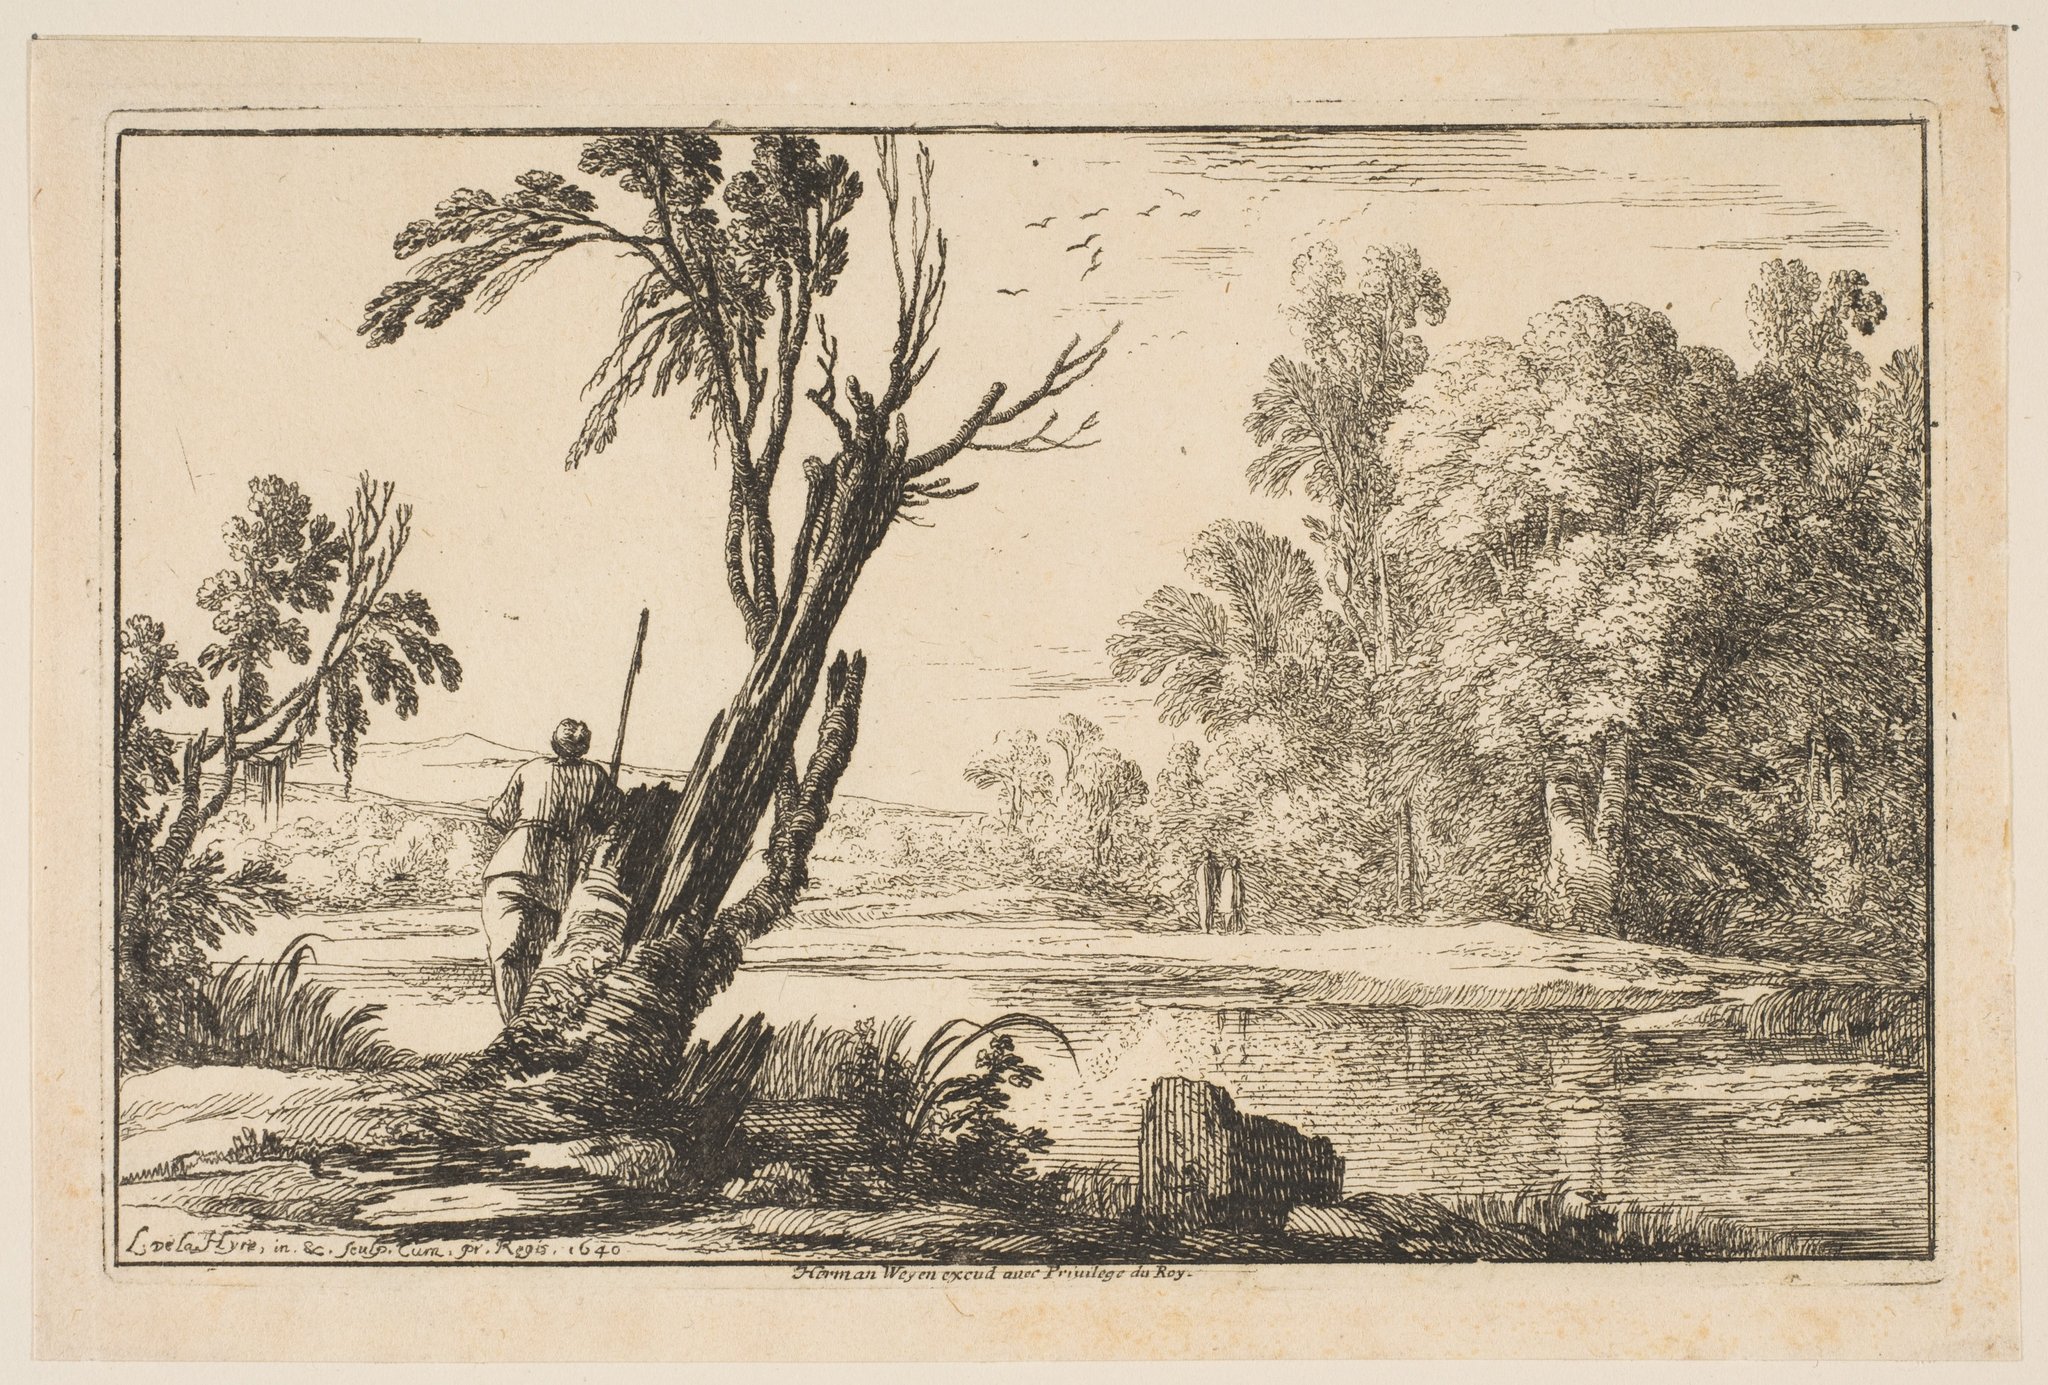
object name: print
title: Man Seen From Behind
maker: laurent de la hyre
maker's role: artist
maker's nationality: french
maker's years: 1606-1656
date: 1640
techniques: etching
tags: men,landscapes